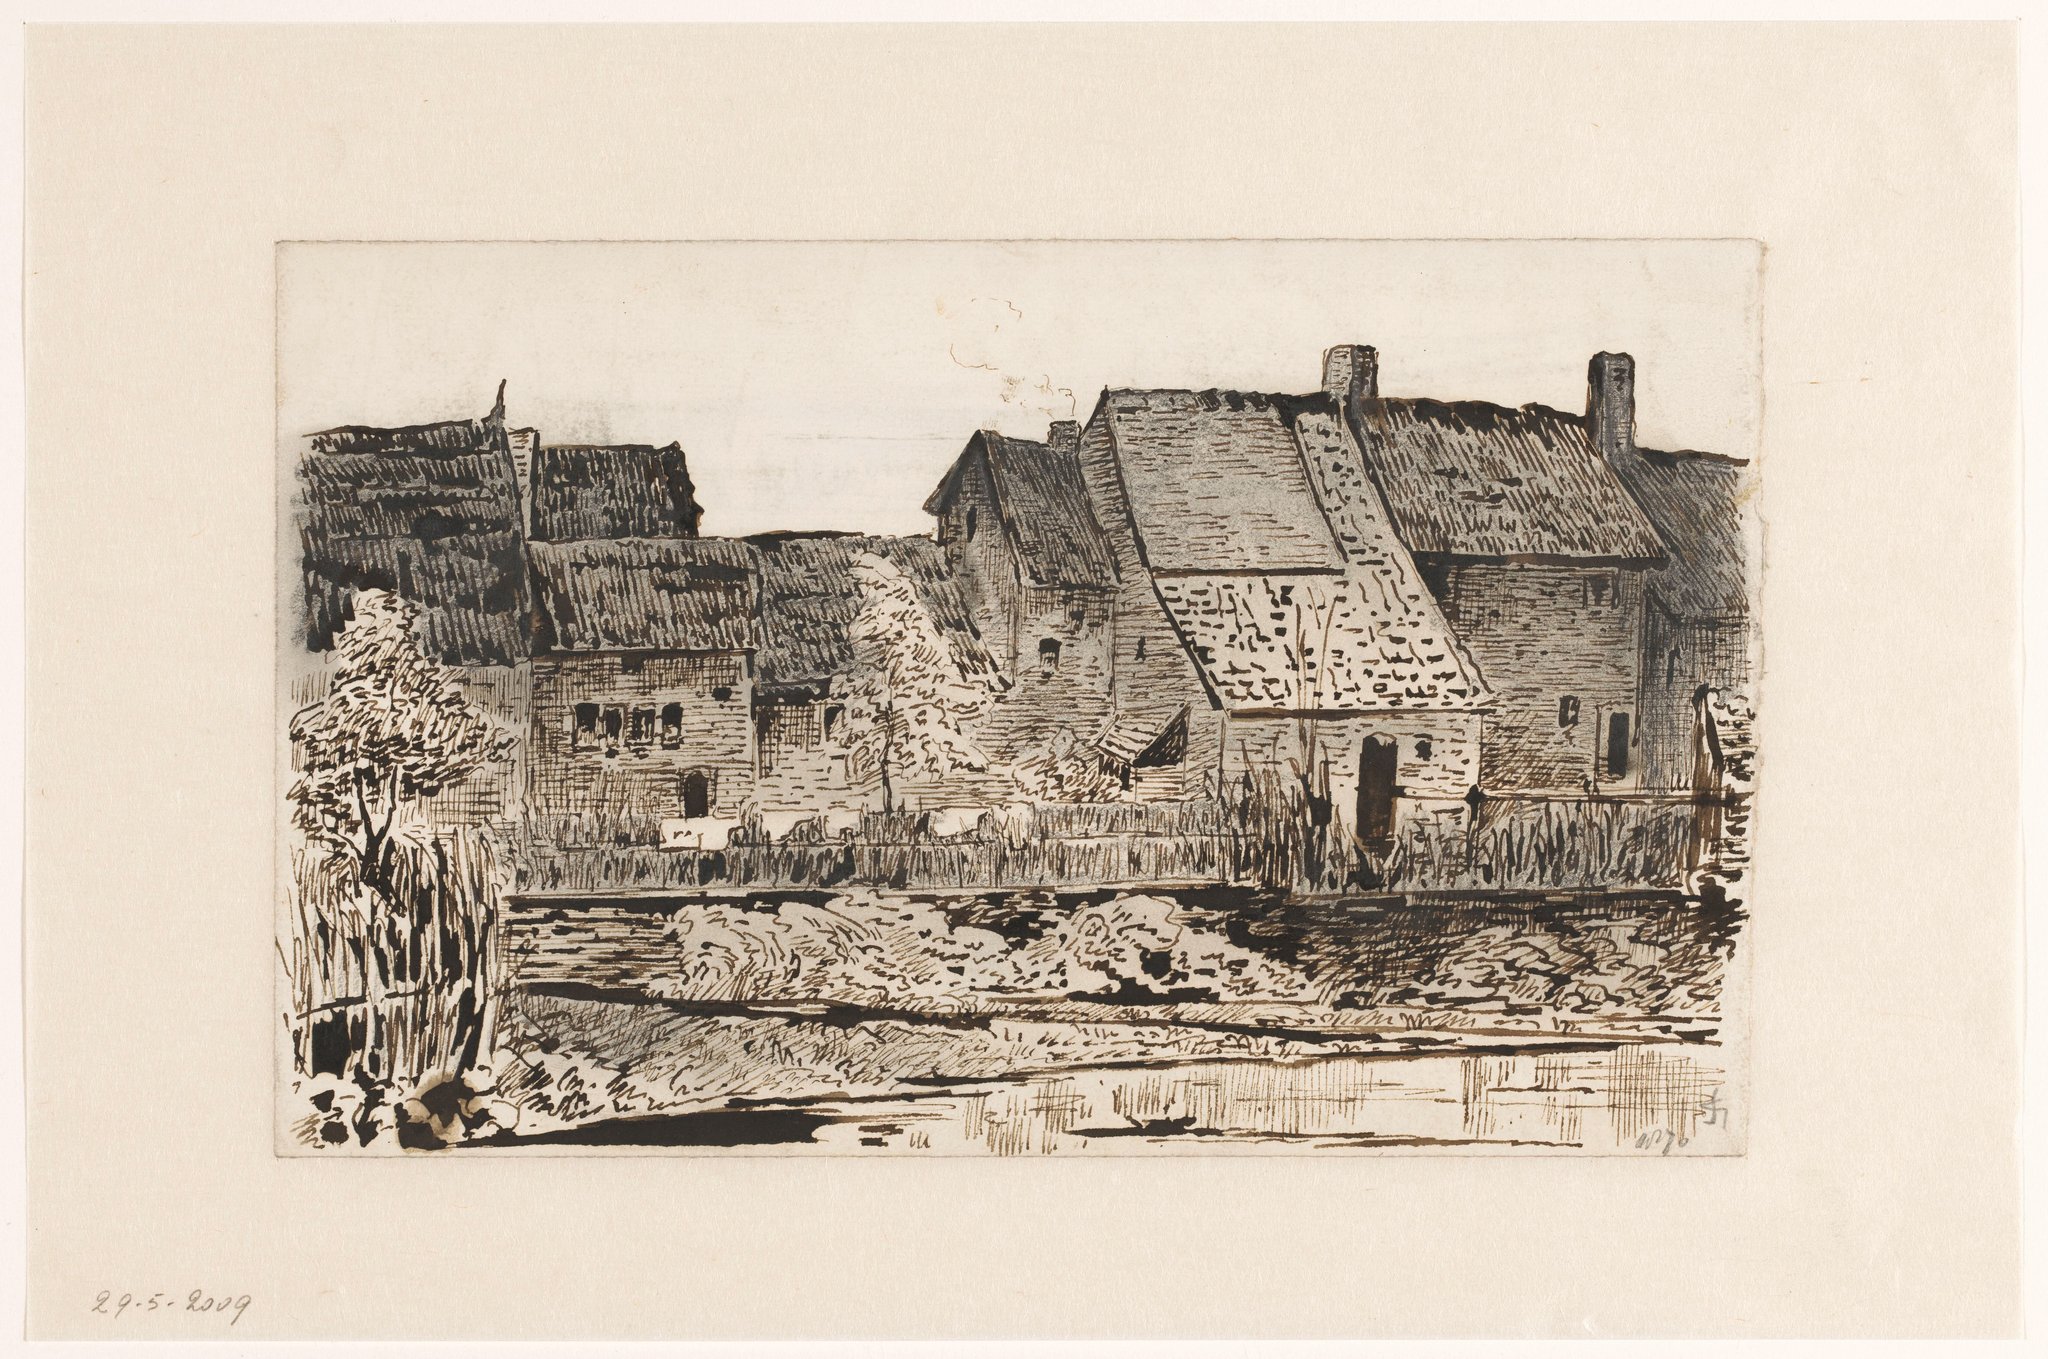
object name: drawing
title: Anhée, dorp aan de Maas bij Dinant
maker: carel nicolaas storm van s-gravesande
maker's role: draughtsman, print maker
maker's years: 1841-1924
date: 1870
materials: paper, pencil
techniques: brush, pen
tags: city-view in general; 'veduta'